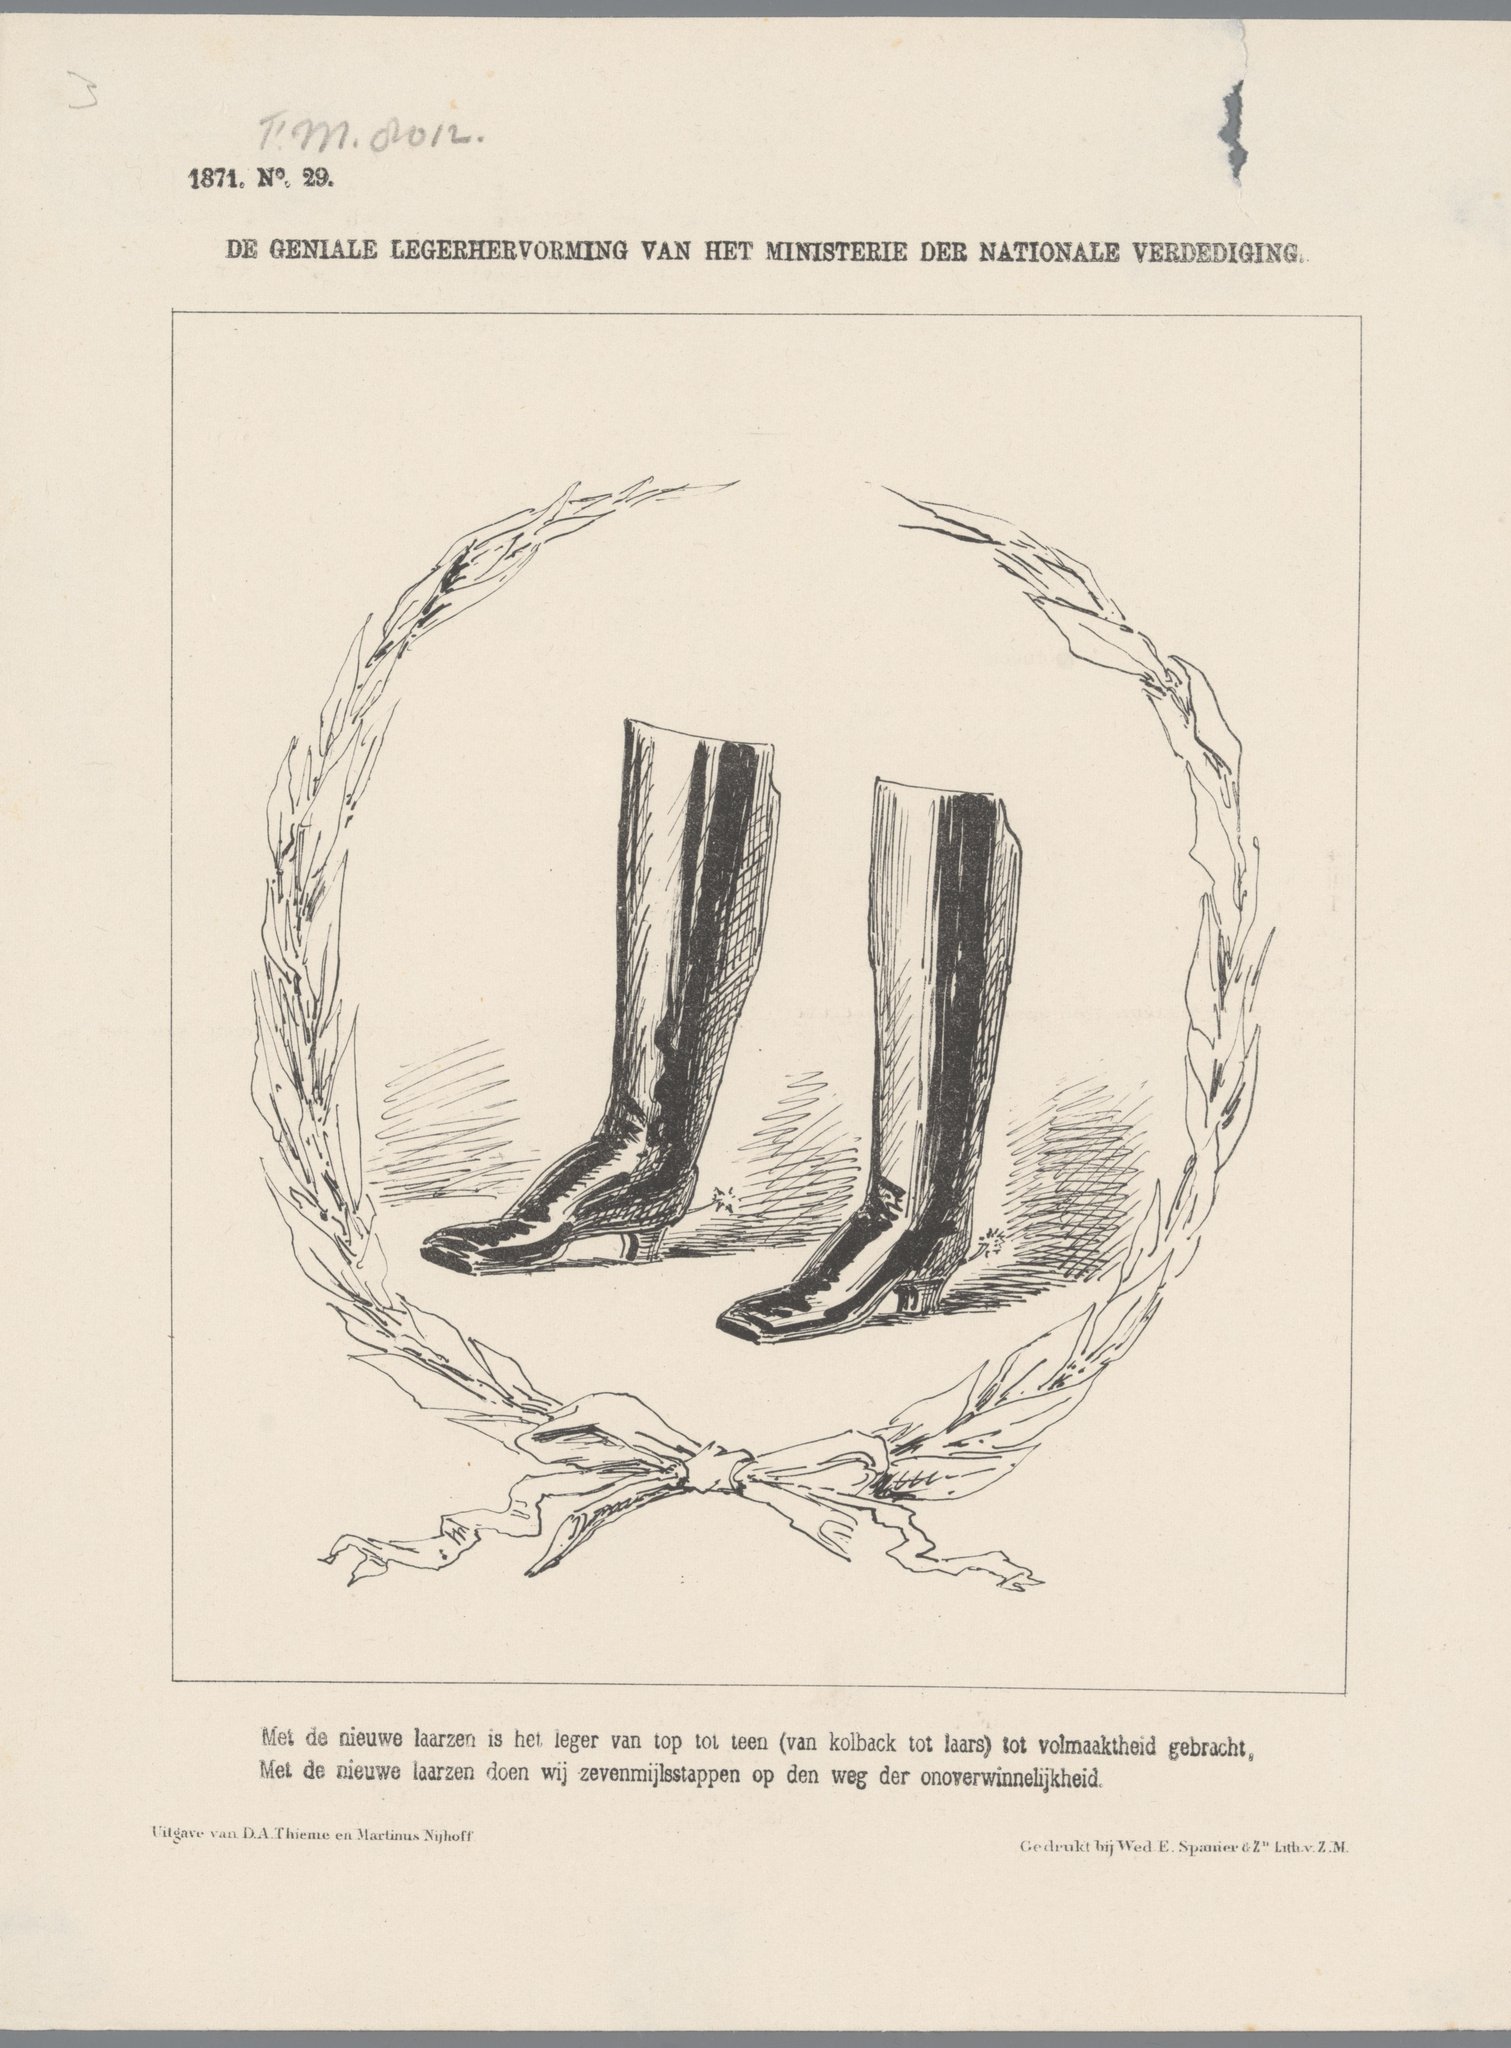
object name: cartoon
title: De geniale legerhervorming van het ministerie der nationale verdediging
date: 1871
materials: paper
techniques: lithograph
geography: netherlands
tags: boots, (military) uniforms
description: Spotprent op de legerhervorming van Minister van Oorlog Engelvaart, die enkel resulteerde in het vaststellen van een nieuw model legerlaarzen. Plaat verschenen bij het weekblad De Nederlandsche Spectator, nr. 29, 1871.